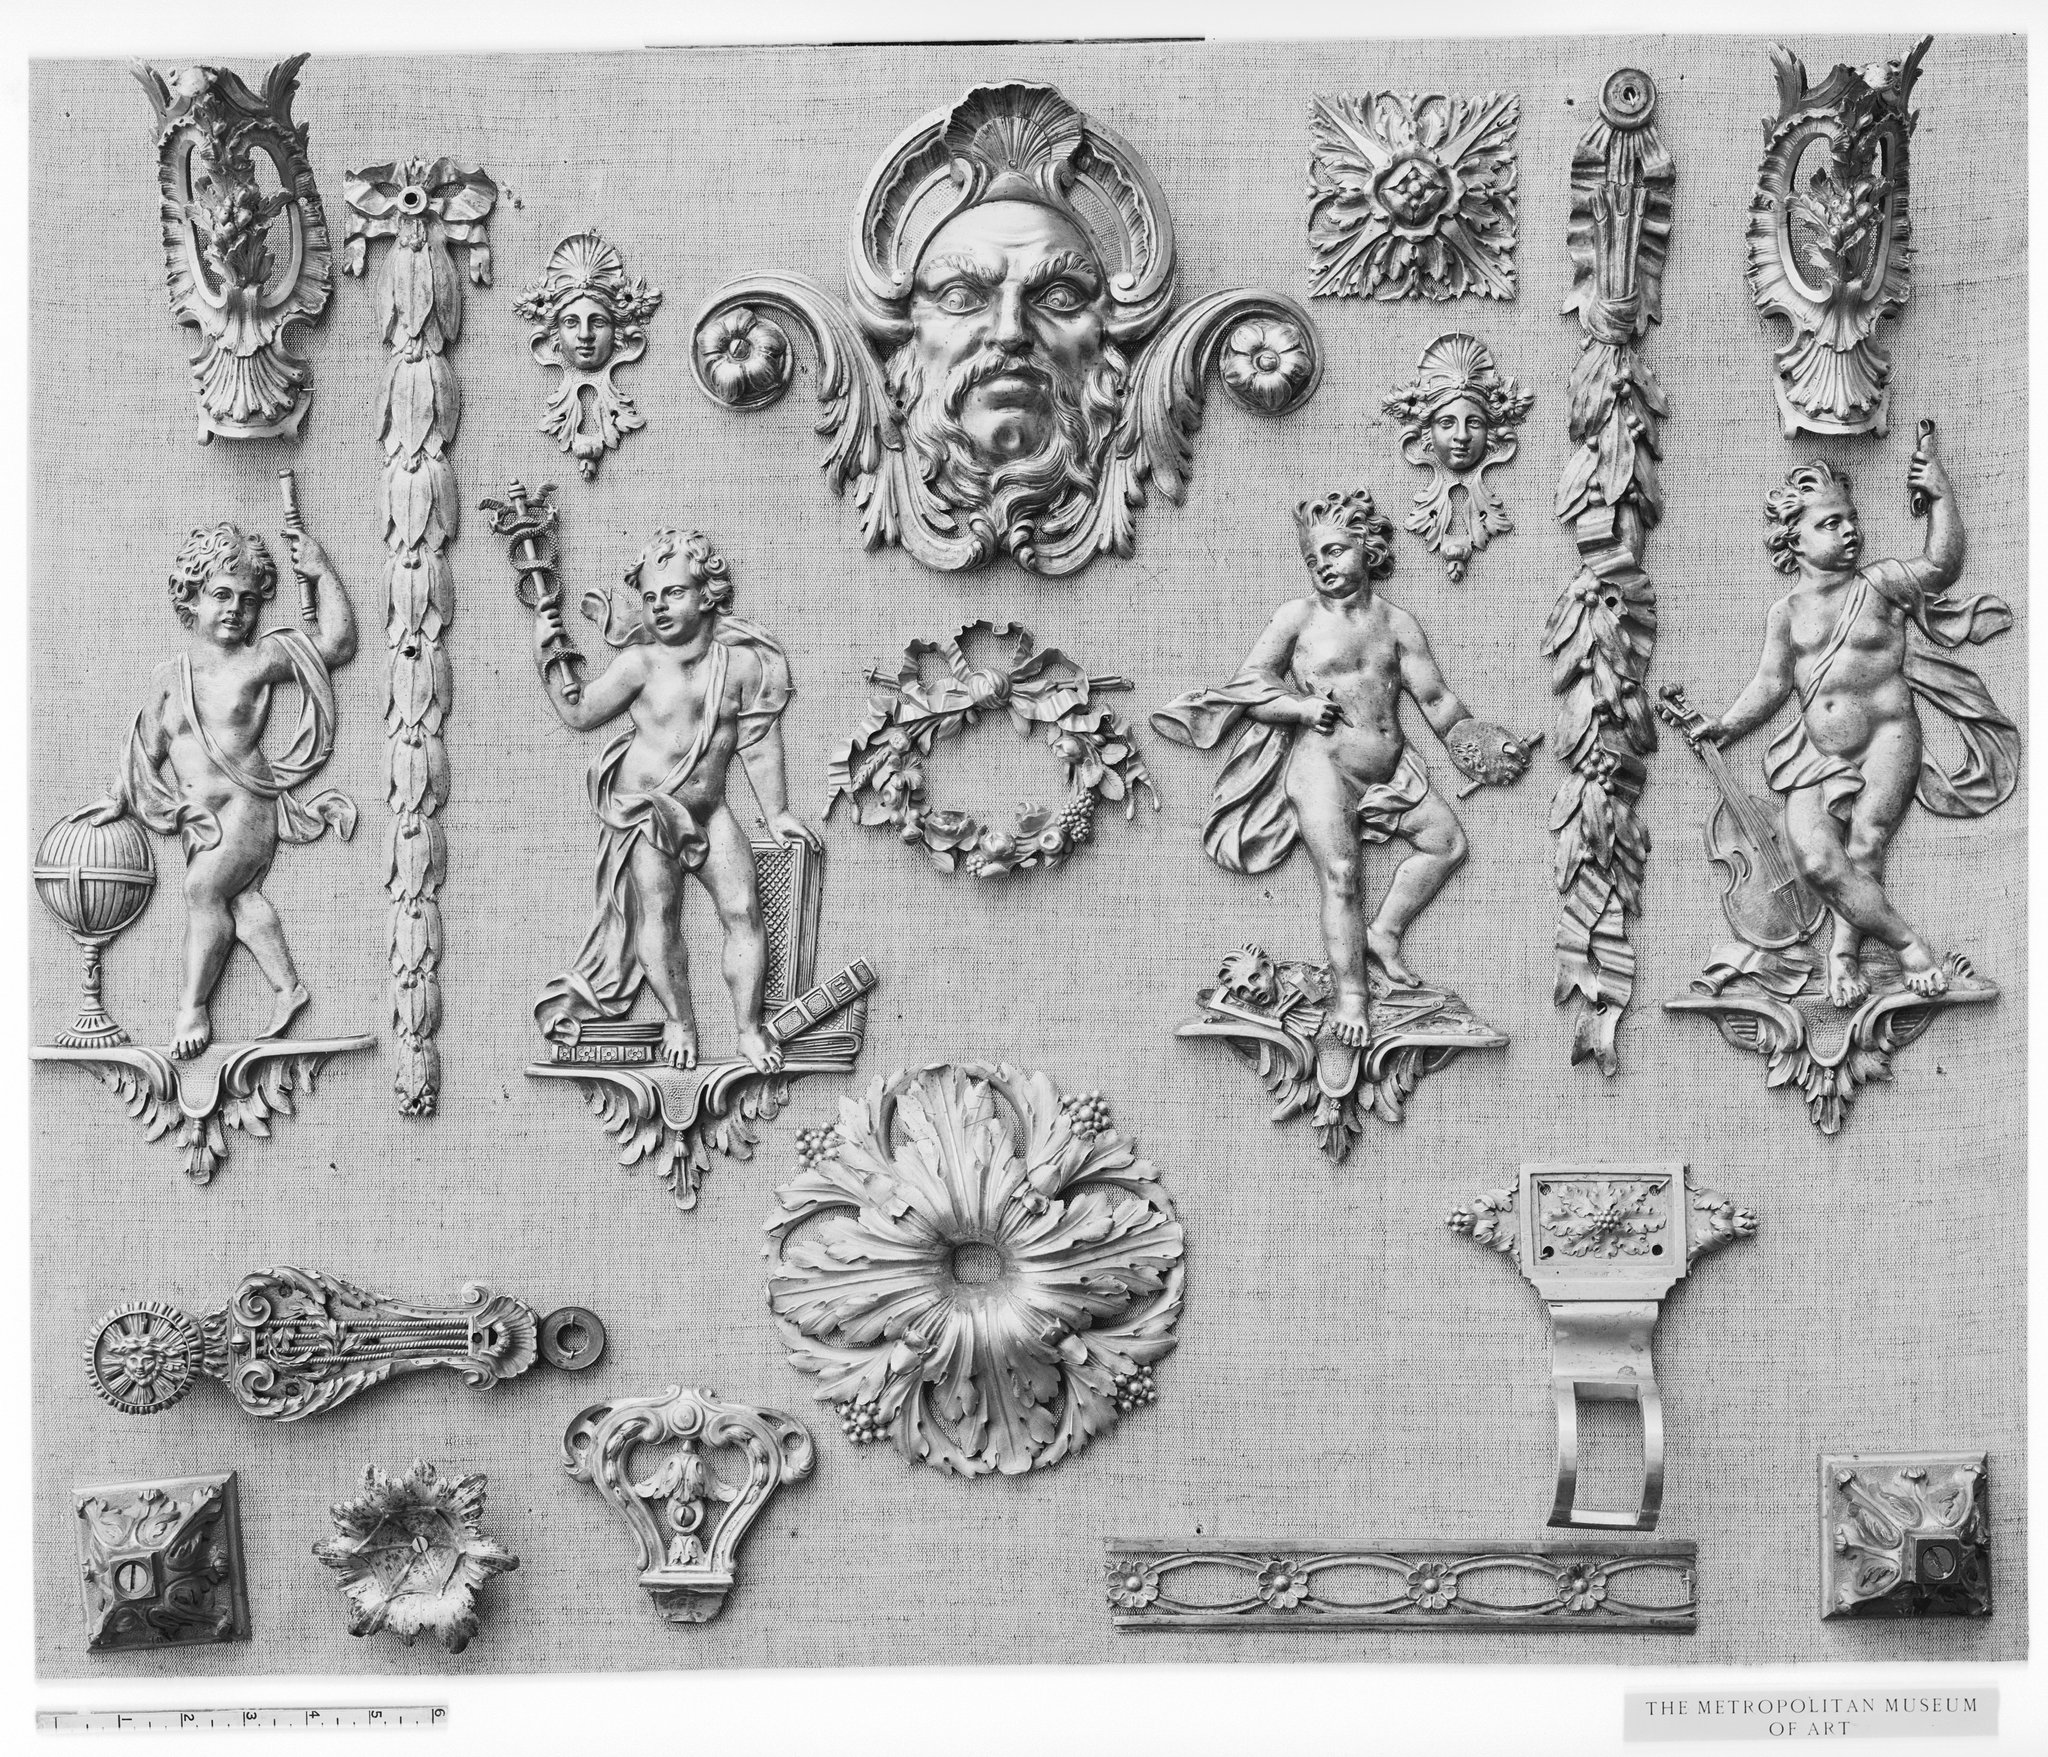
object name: frieze part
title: Frieze fragment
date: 1701-1800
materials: gilt bronze